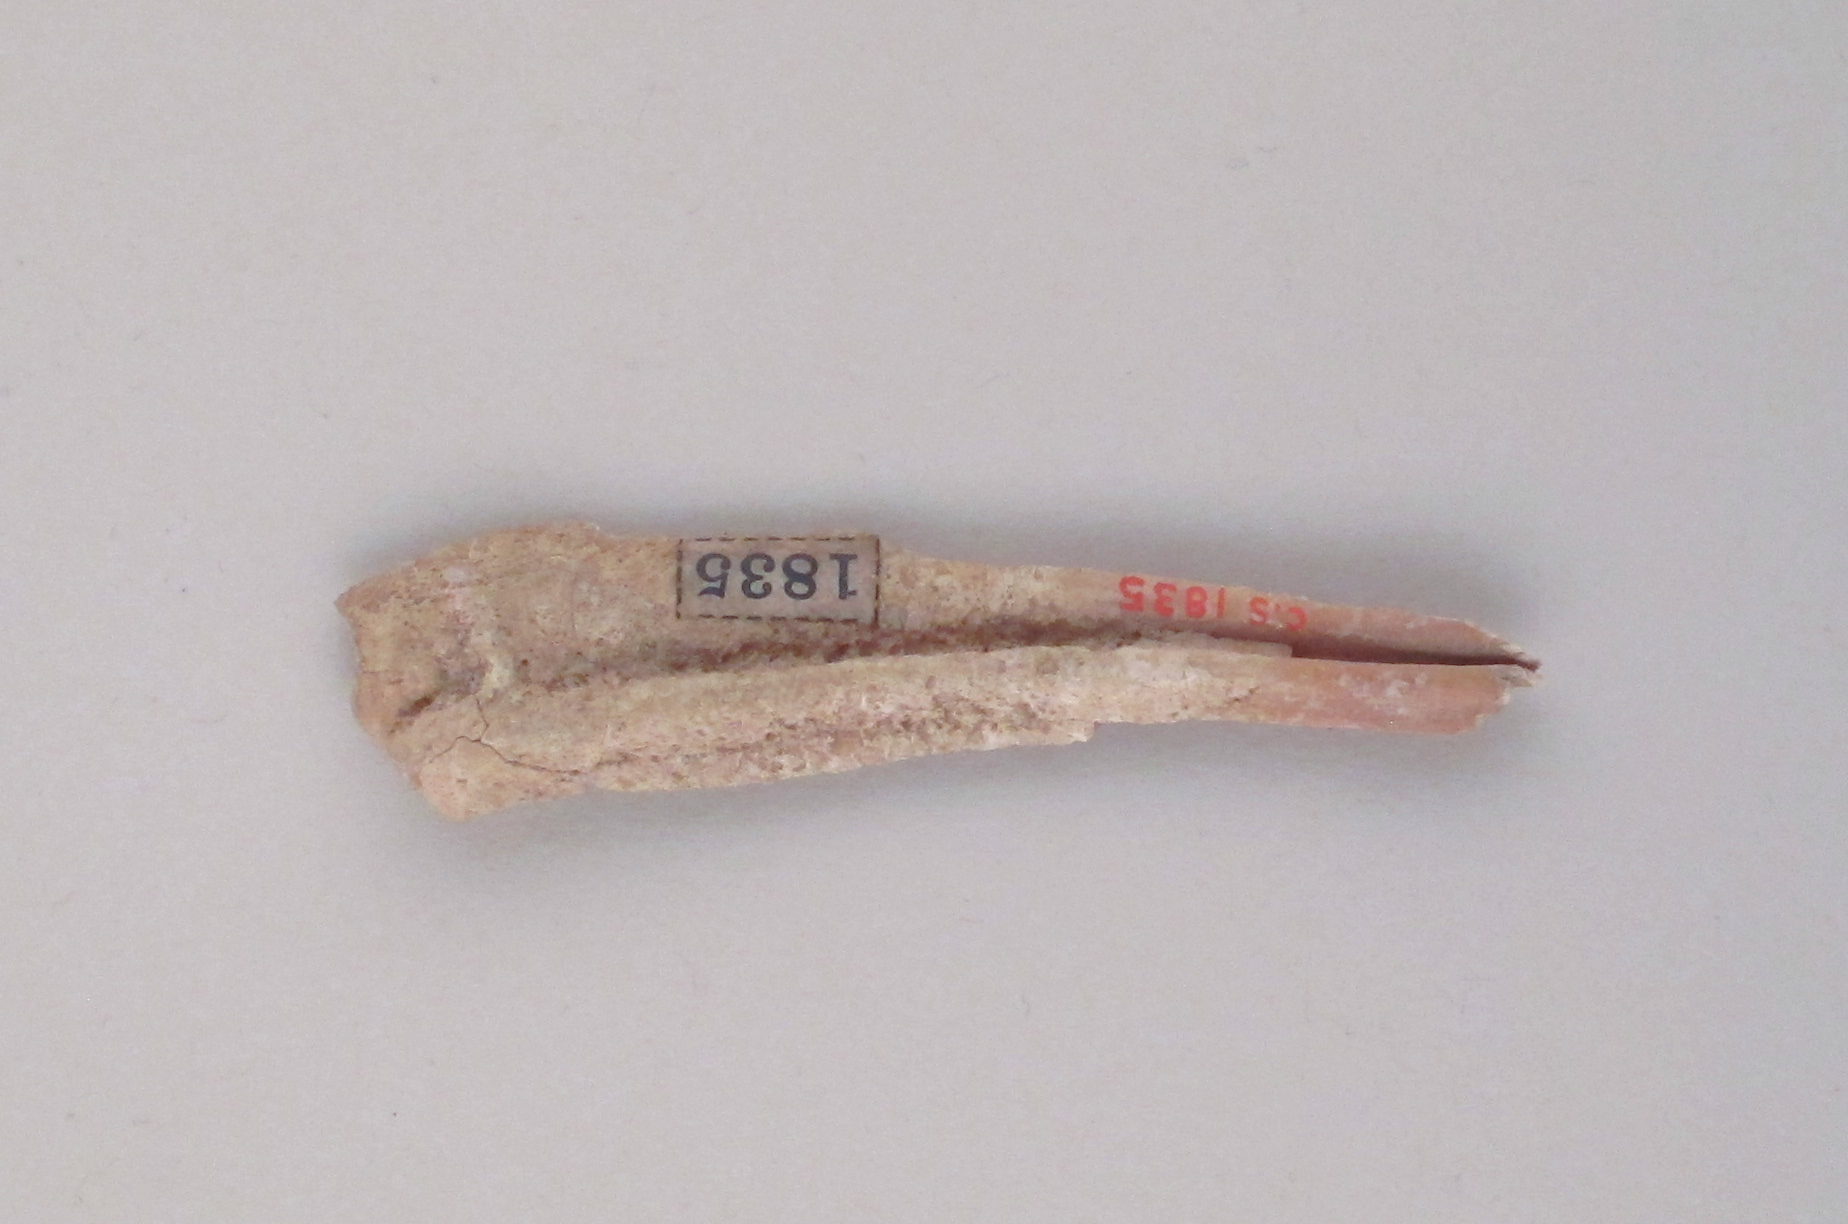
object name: tooth of an ox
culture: cypriot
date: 3900 BCE-100 CE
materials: bone